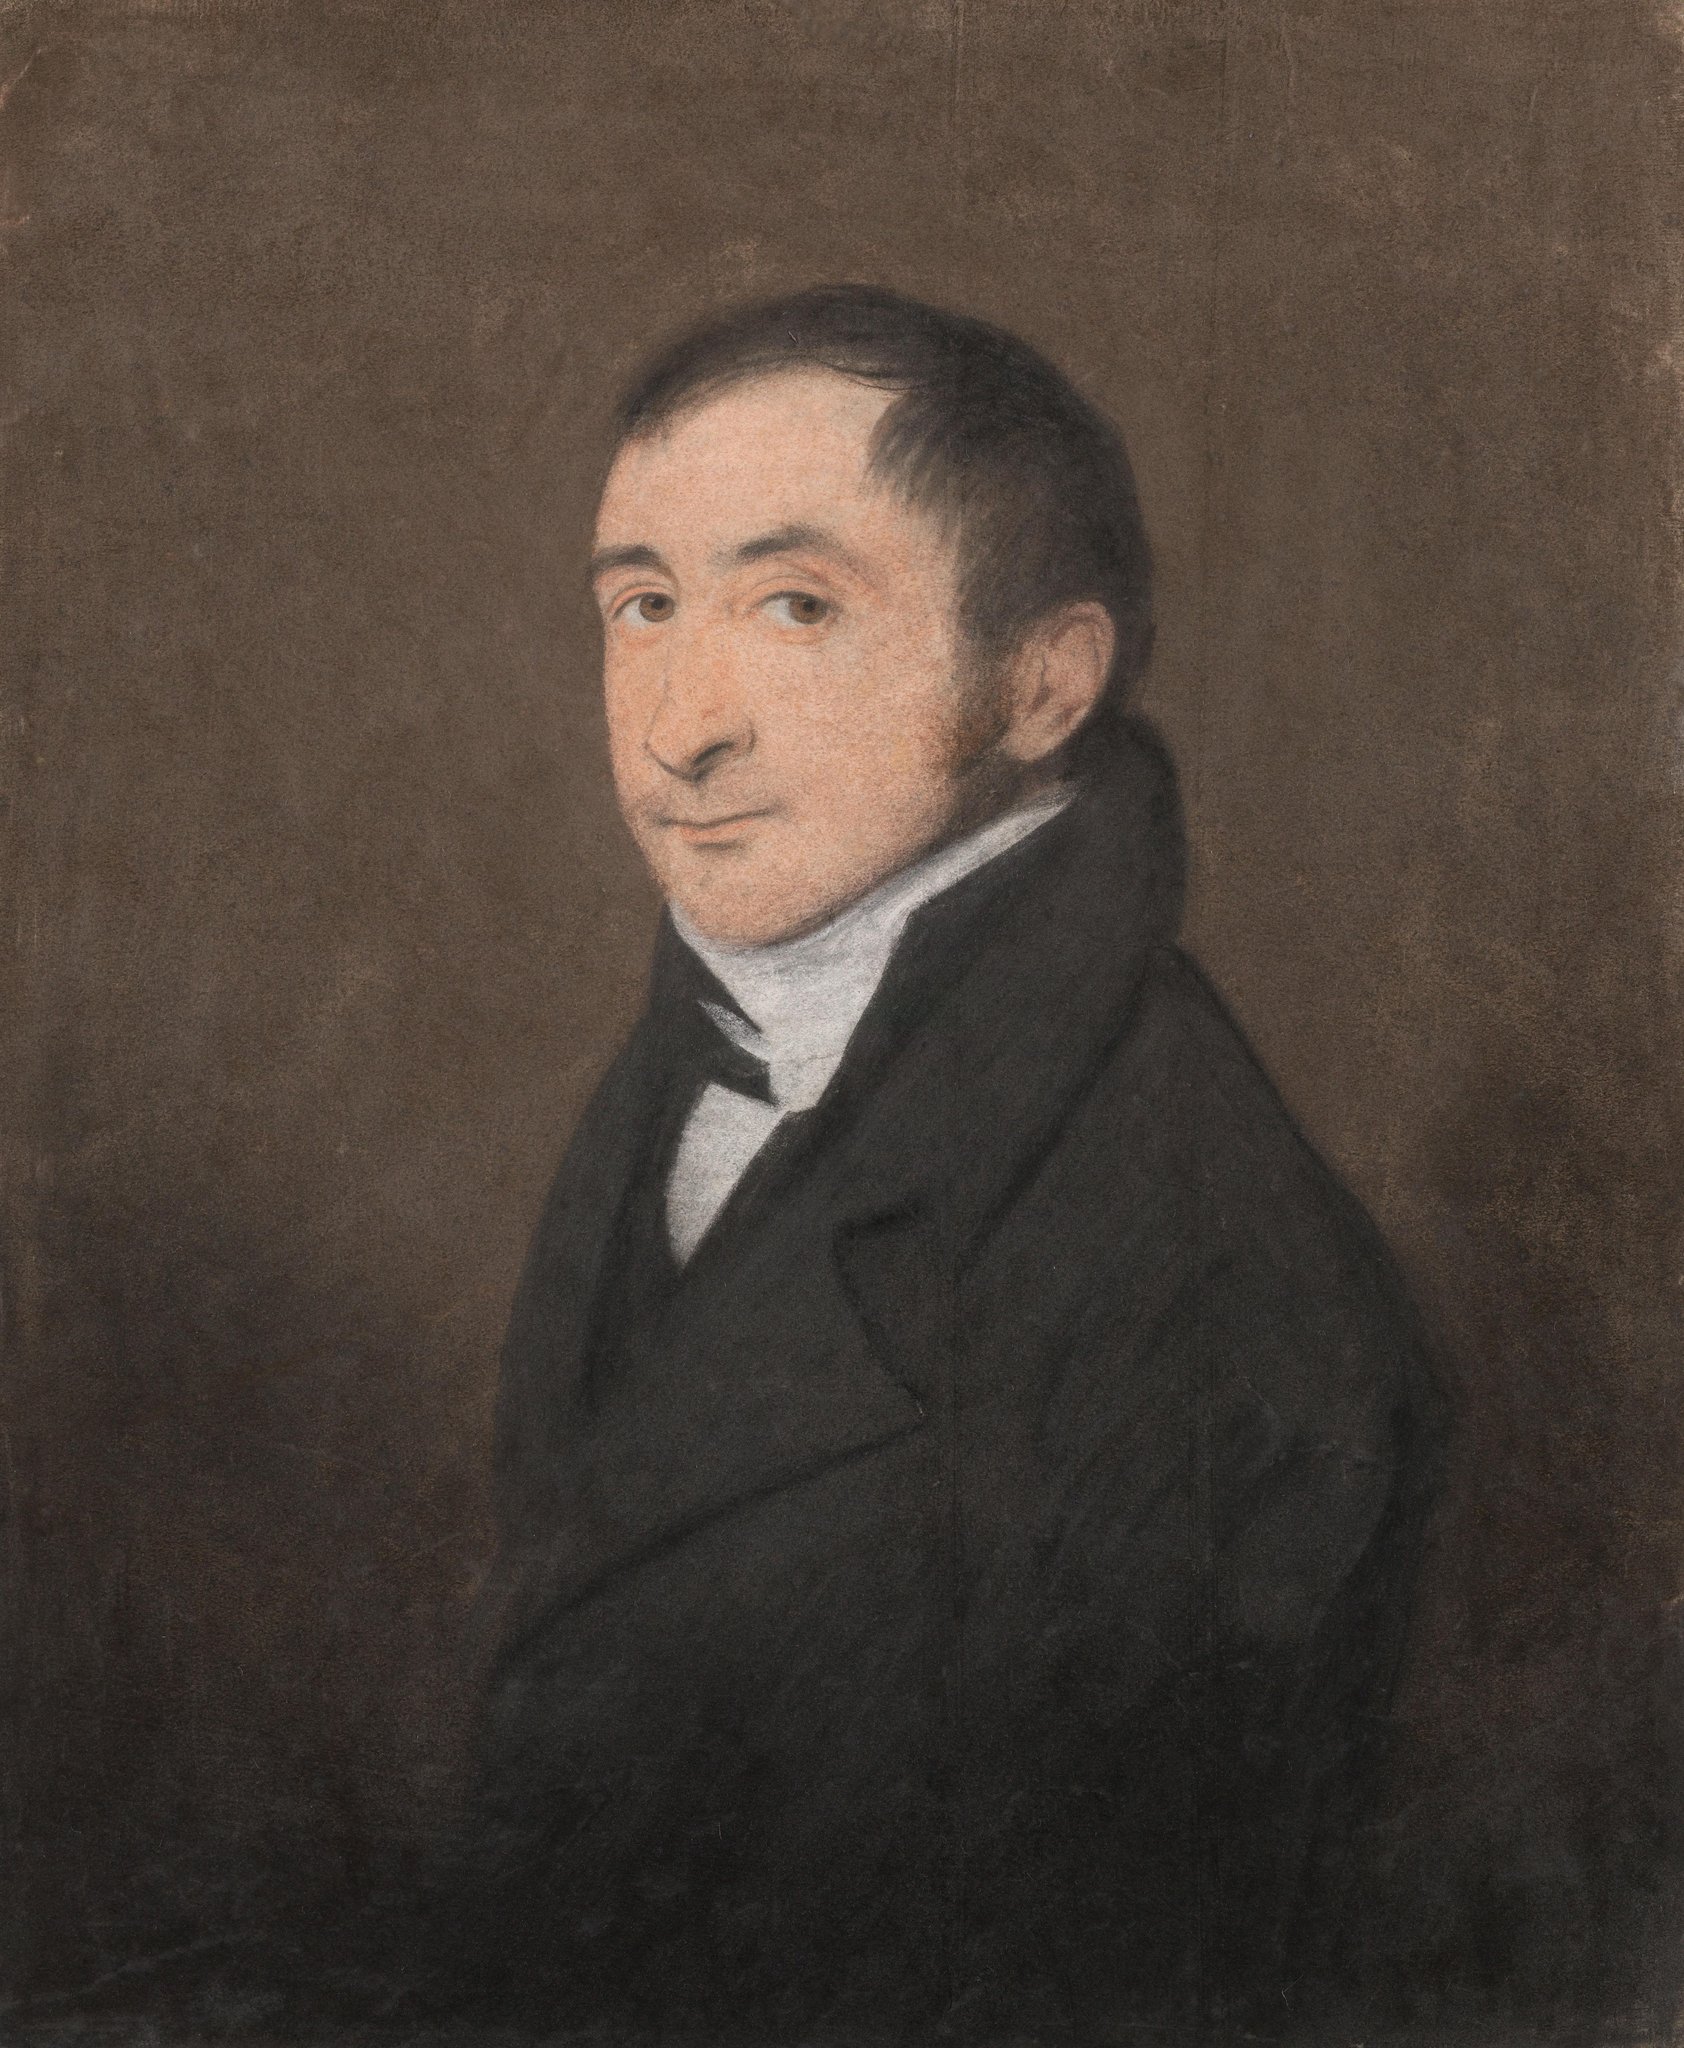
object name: drawing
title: Portret van een man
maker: Anonymous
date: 1820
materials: glass, parchment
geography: northern netherlands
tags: historical persons not known by name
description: Portret van een man. Buste naar links, aanziend. Onderdeel van de collectie pastels.